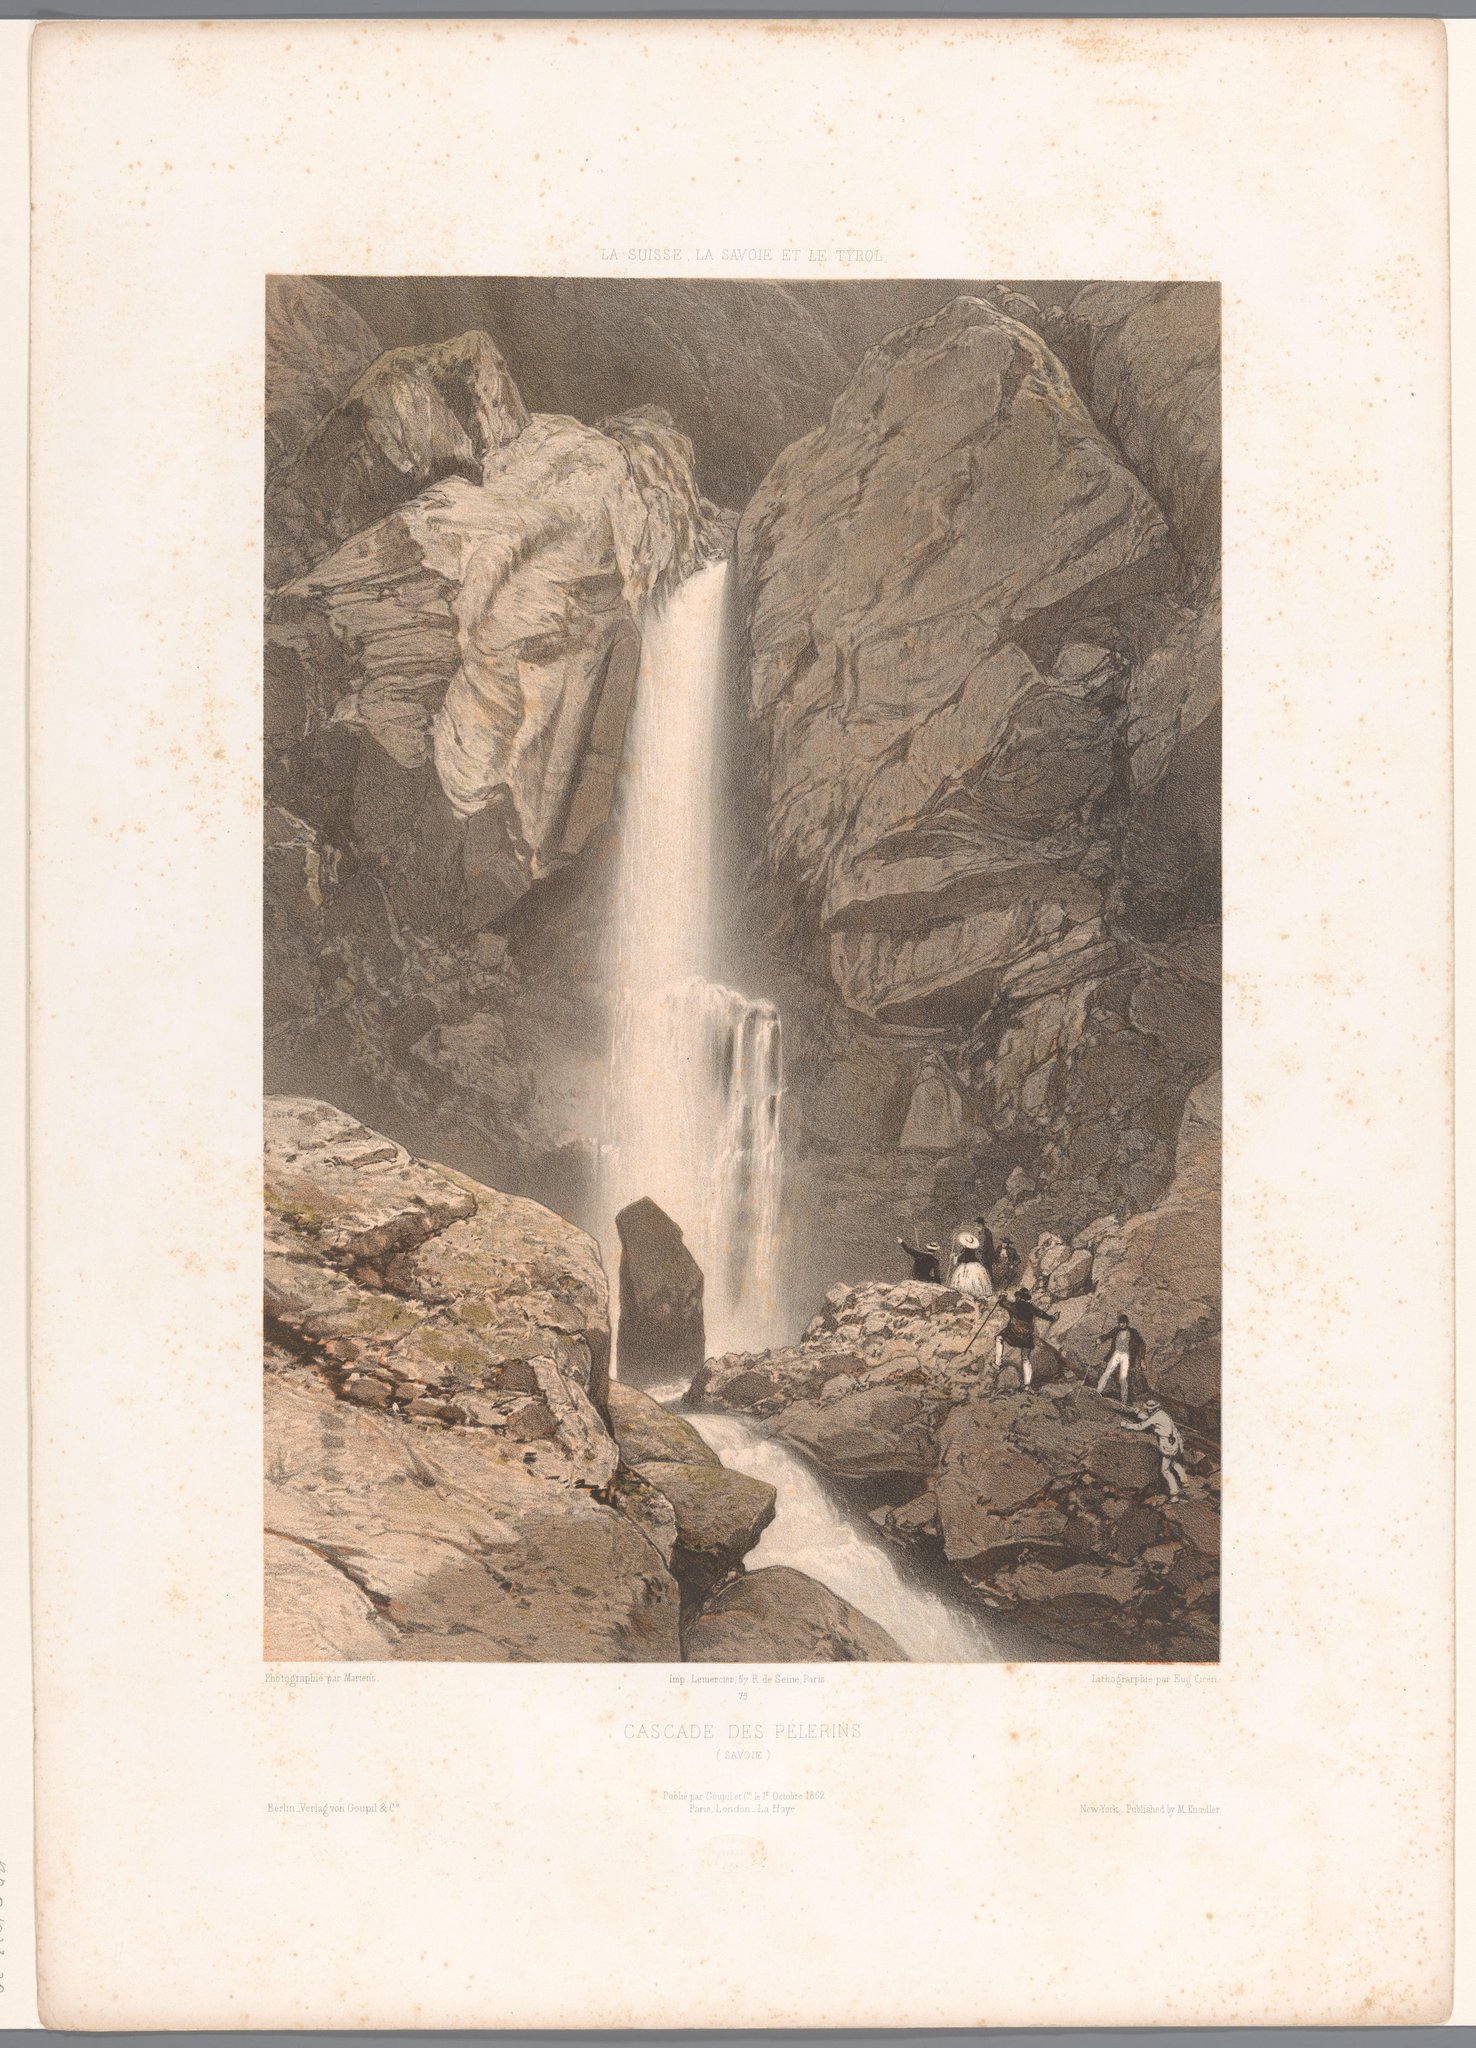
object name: print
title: La Suisse, la Savoie et le Tyrol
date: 1859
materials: paper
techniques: lithograph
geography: paris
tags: waterfall (+ landscape with figures, staffage), ravine, chasm, abyss, canyon (+ landscape with figures, staffage)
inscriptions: check stamp: Lugt 1090